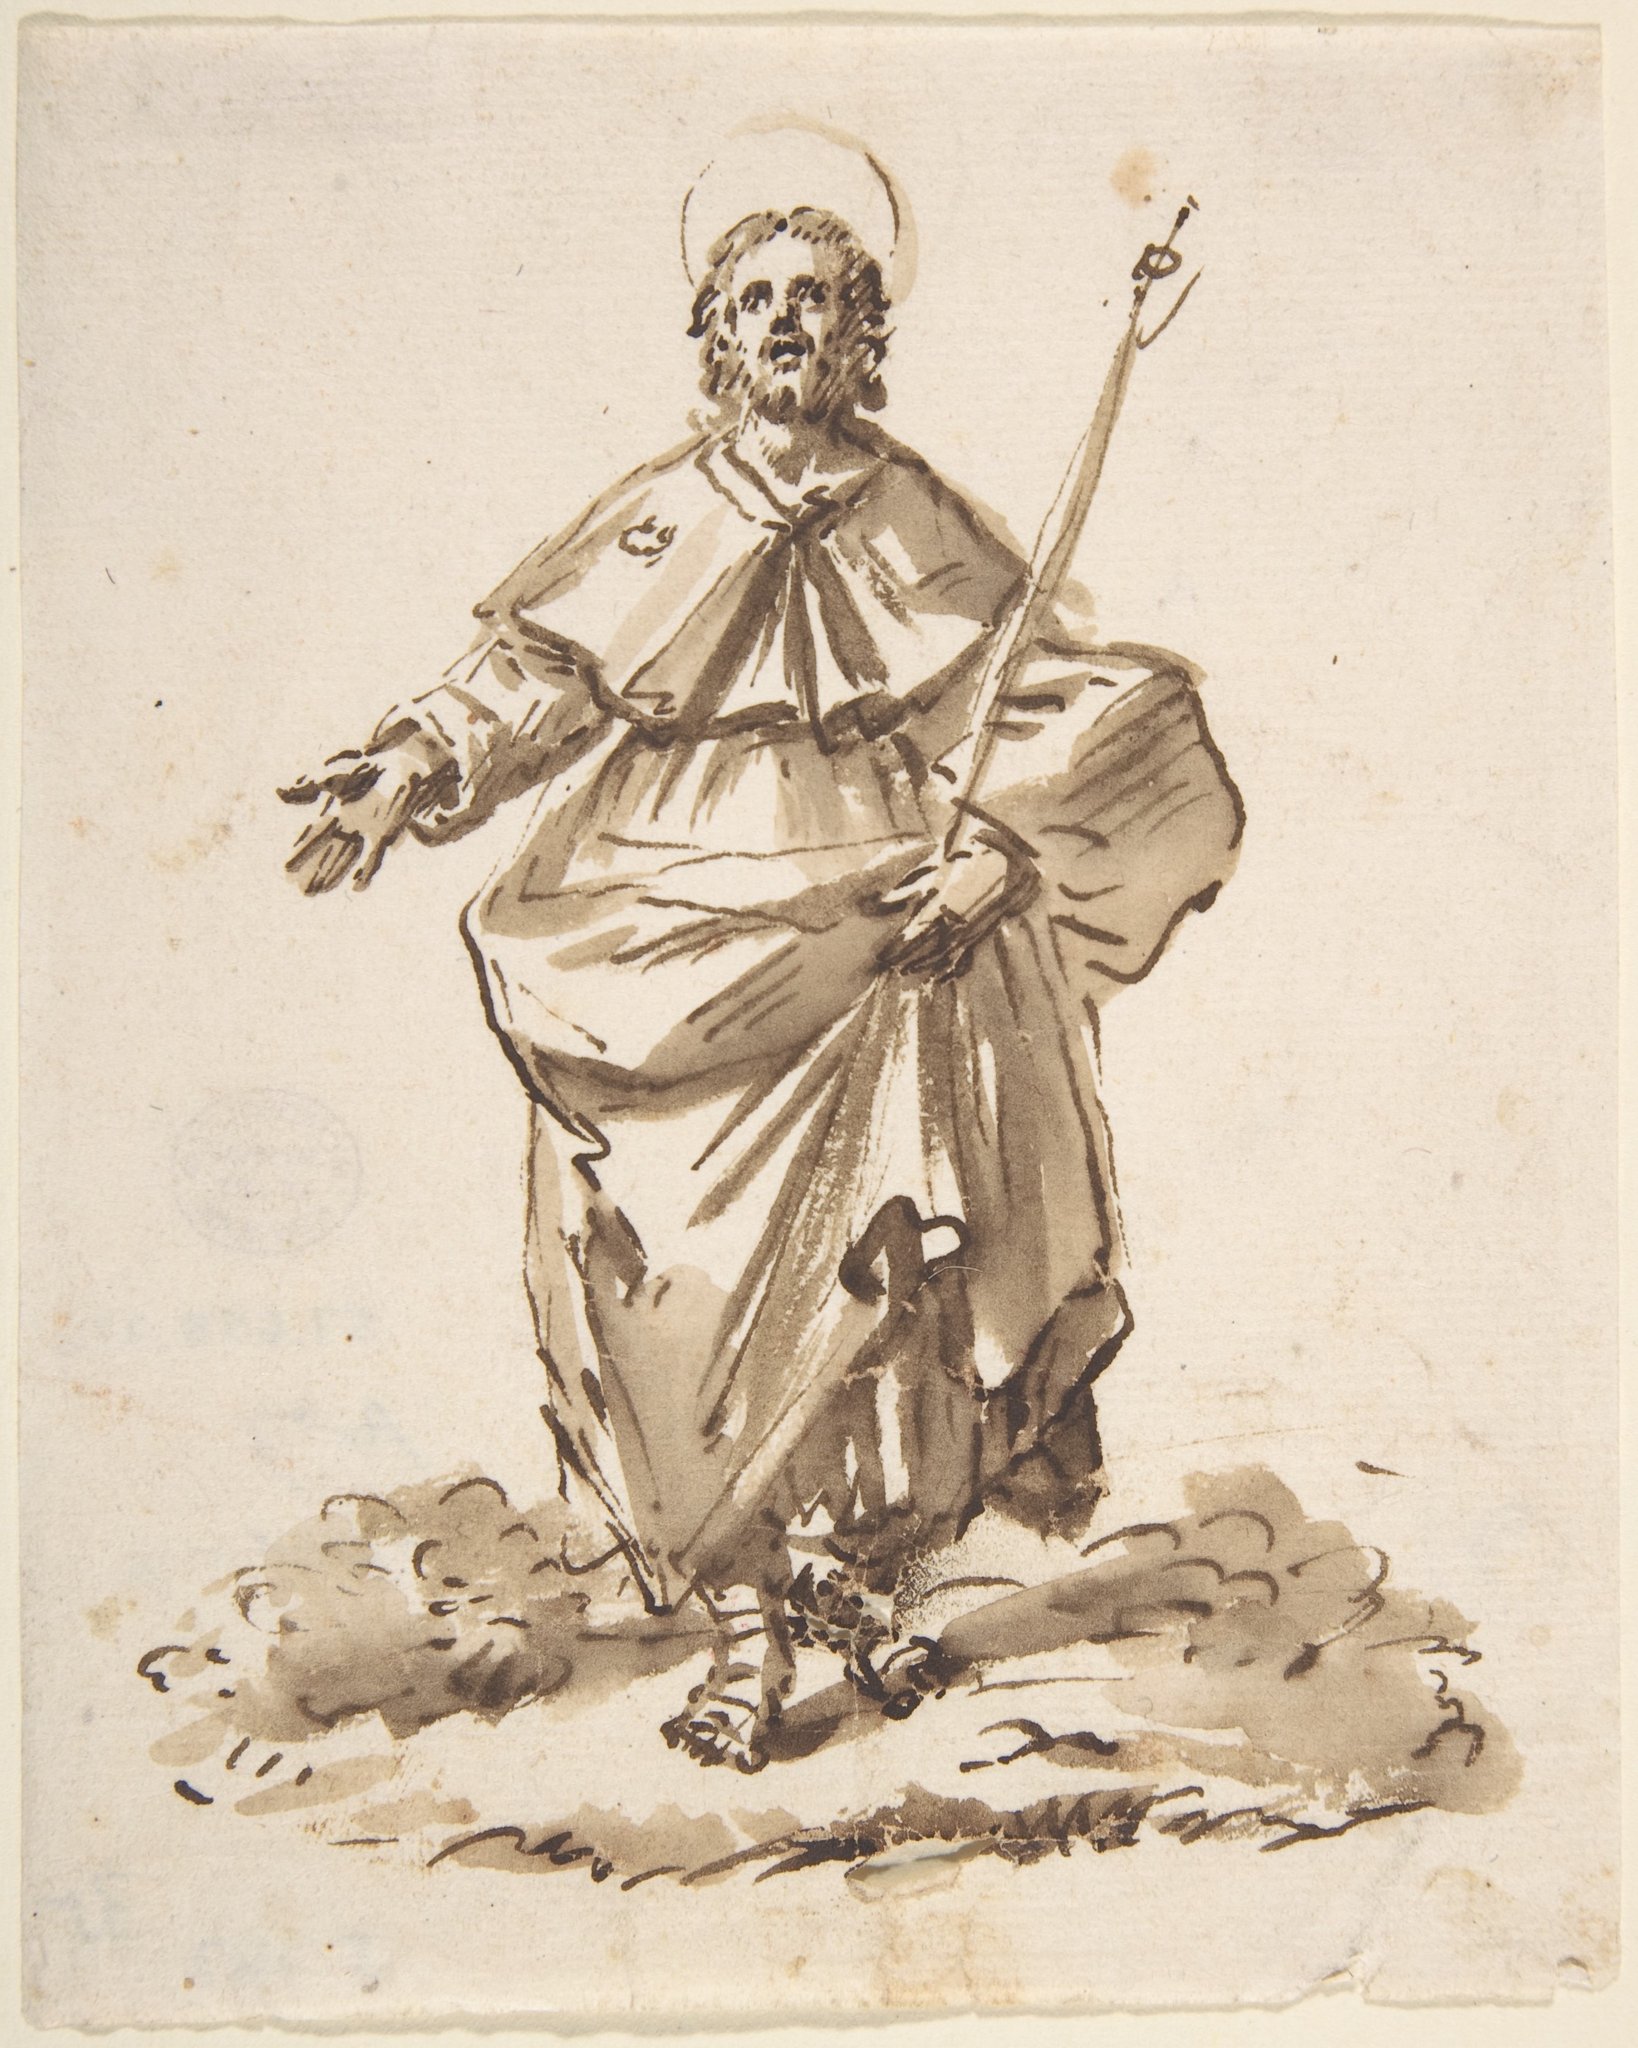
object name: drawing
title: Sketch of a Standing Male Saint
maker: anonymous, italian, north italy, 18th century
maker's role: artist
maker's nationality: italian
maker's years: 1700-1800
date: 1800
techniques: pen, wash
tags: men,saints